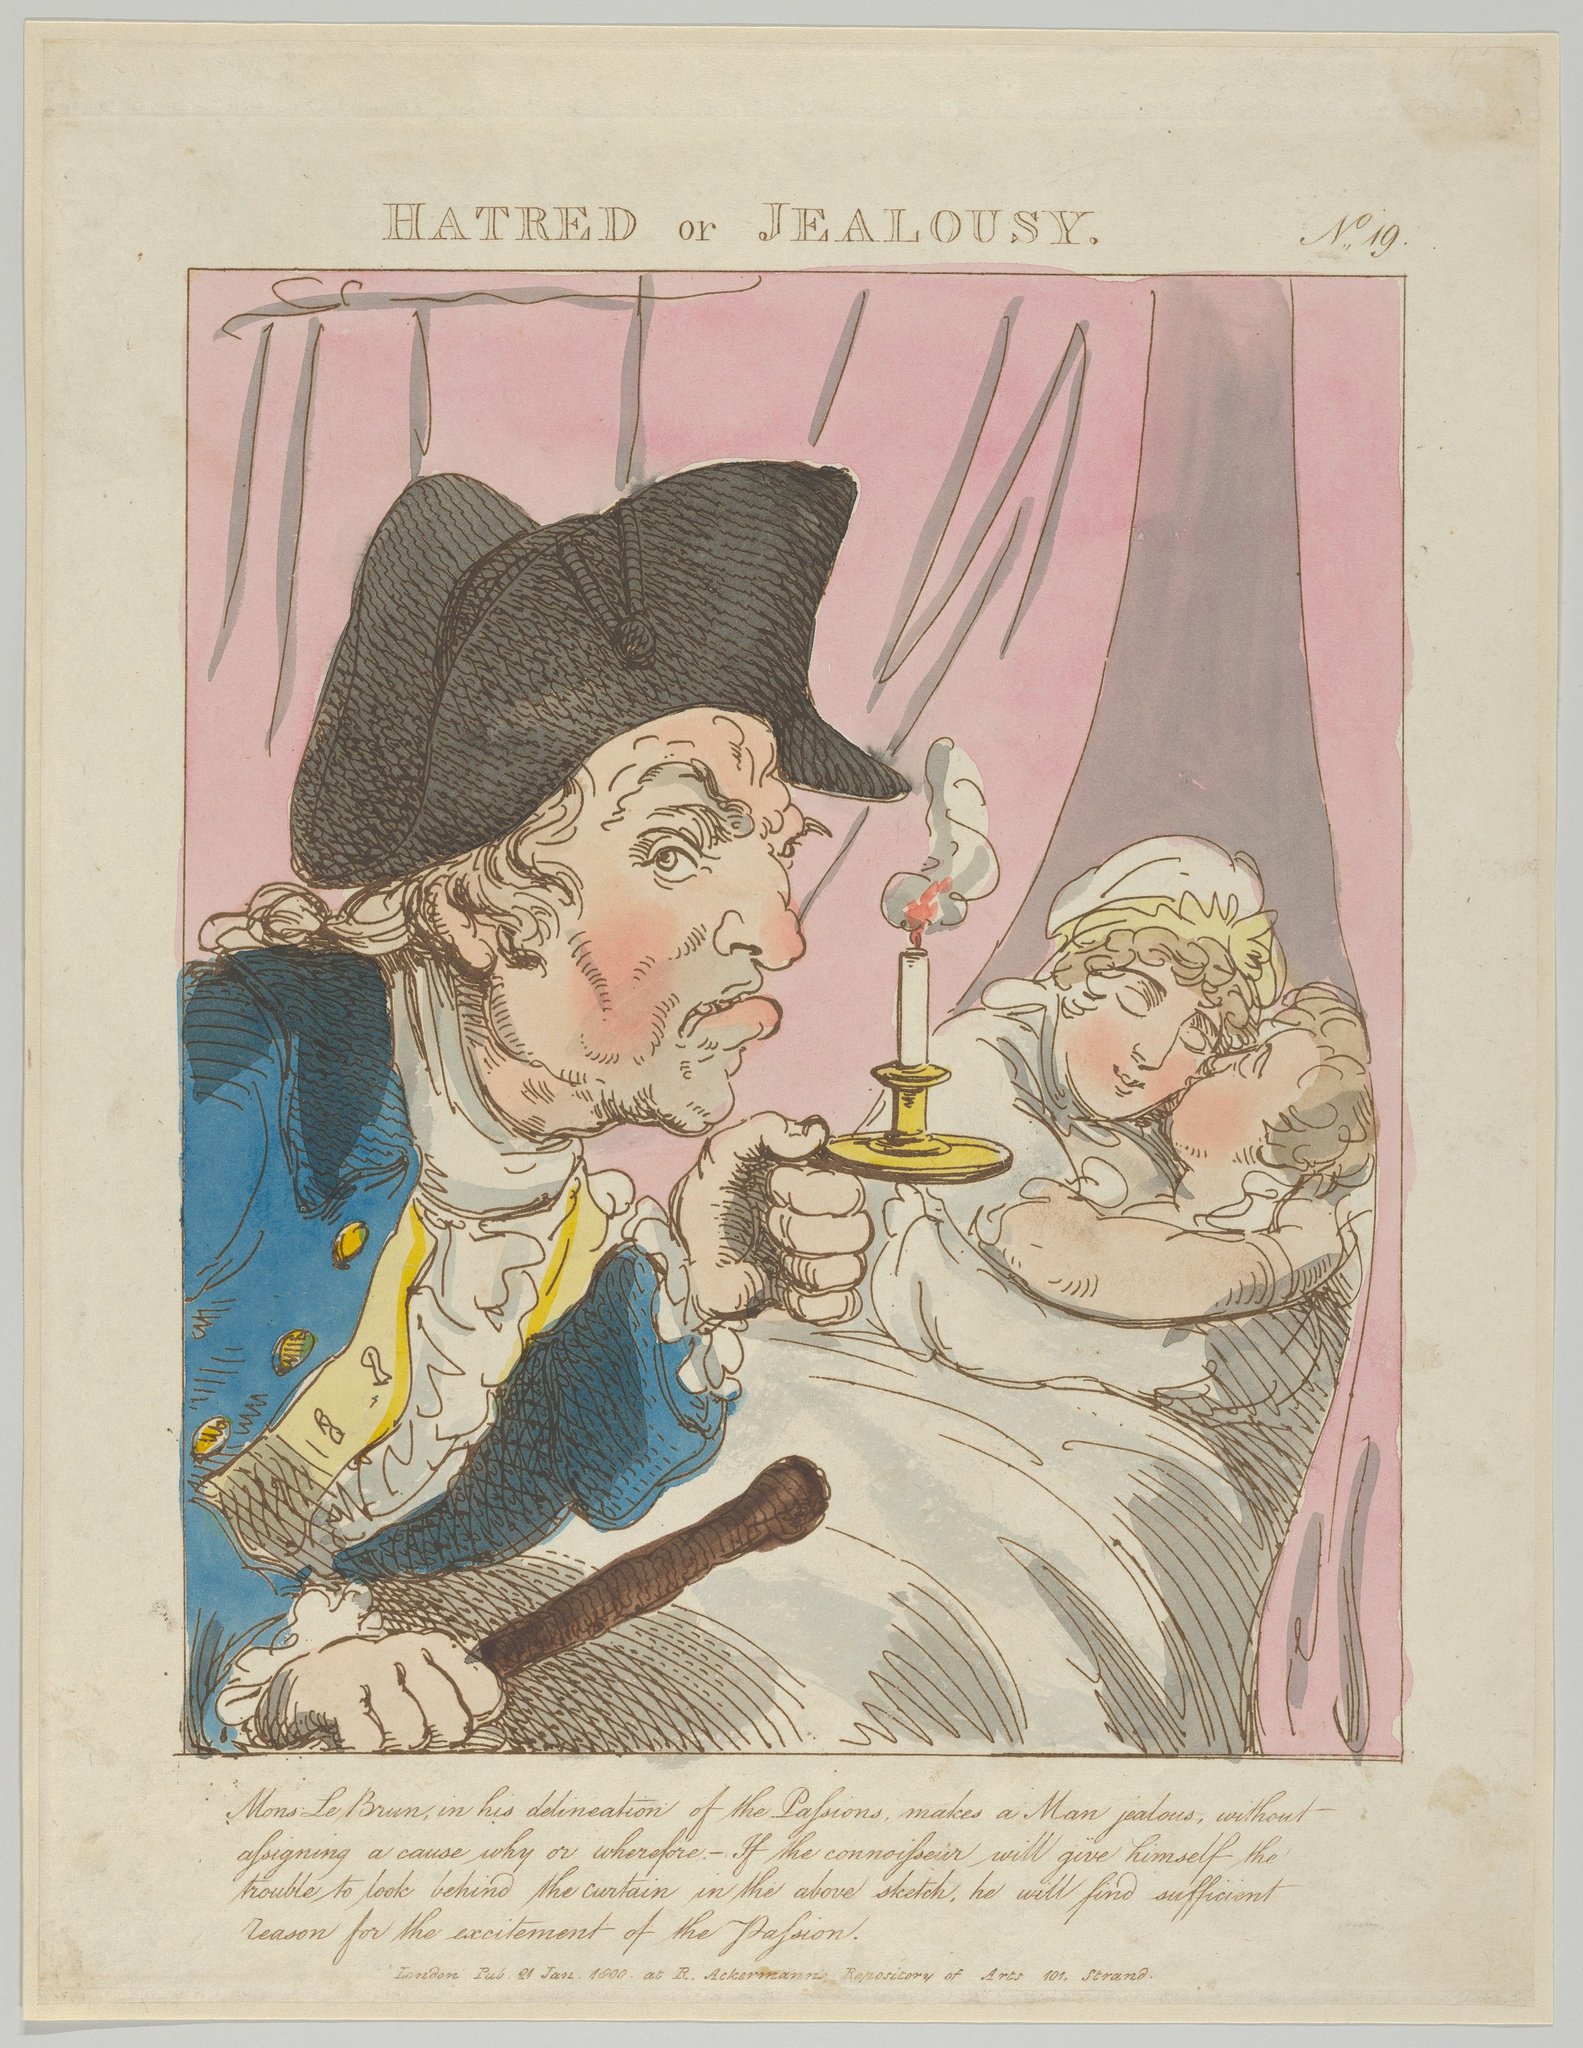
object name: print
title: Hatred or Jealousy (Le Brun Travested, or Caricatures of the Passions)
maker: thomas rowlandson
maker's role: artist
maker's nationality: british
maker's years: 1757-1827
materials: ink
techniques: etching, printing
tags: men,lovers,women